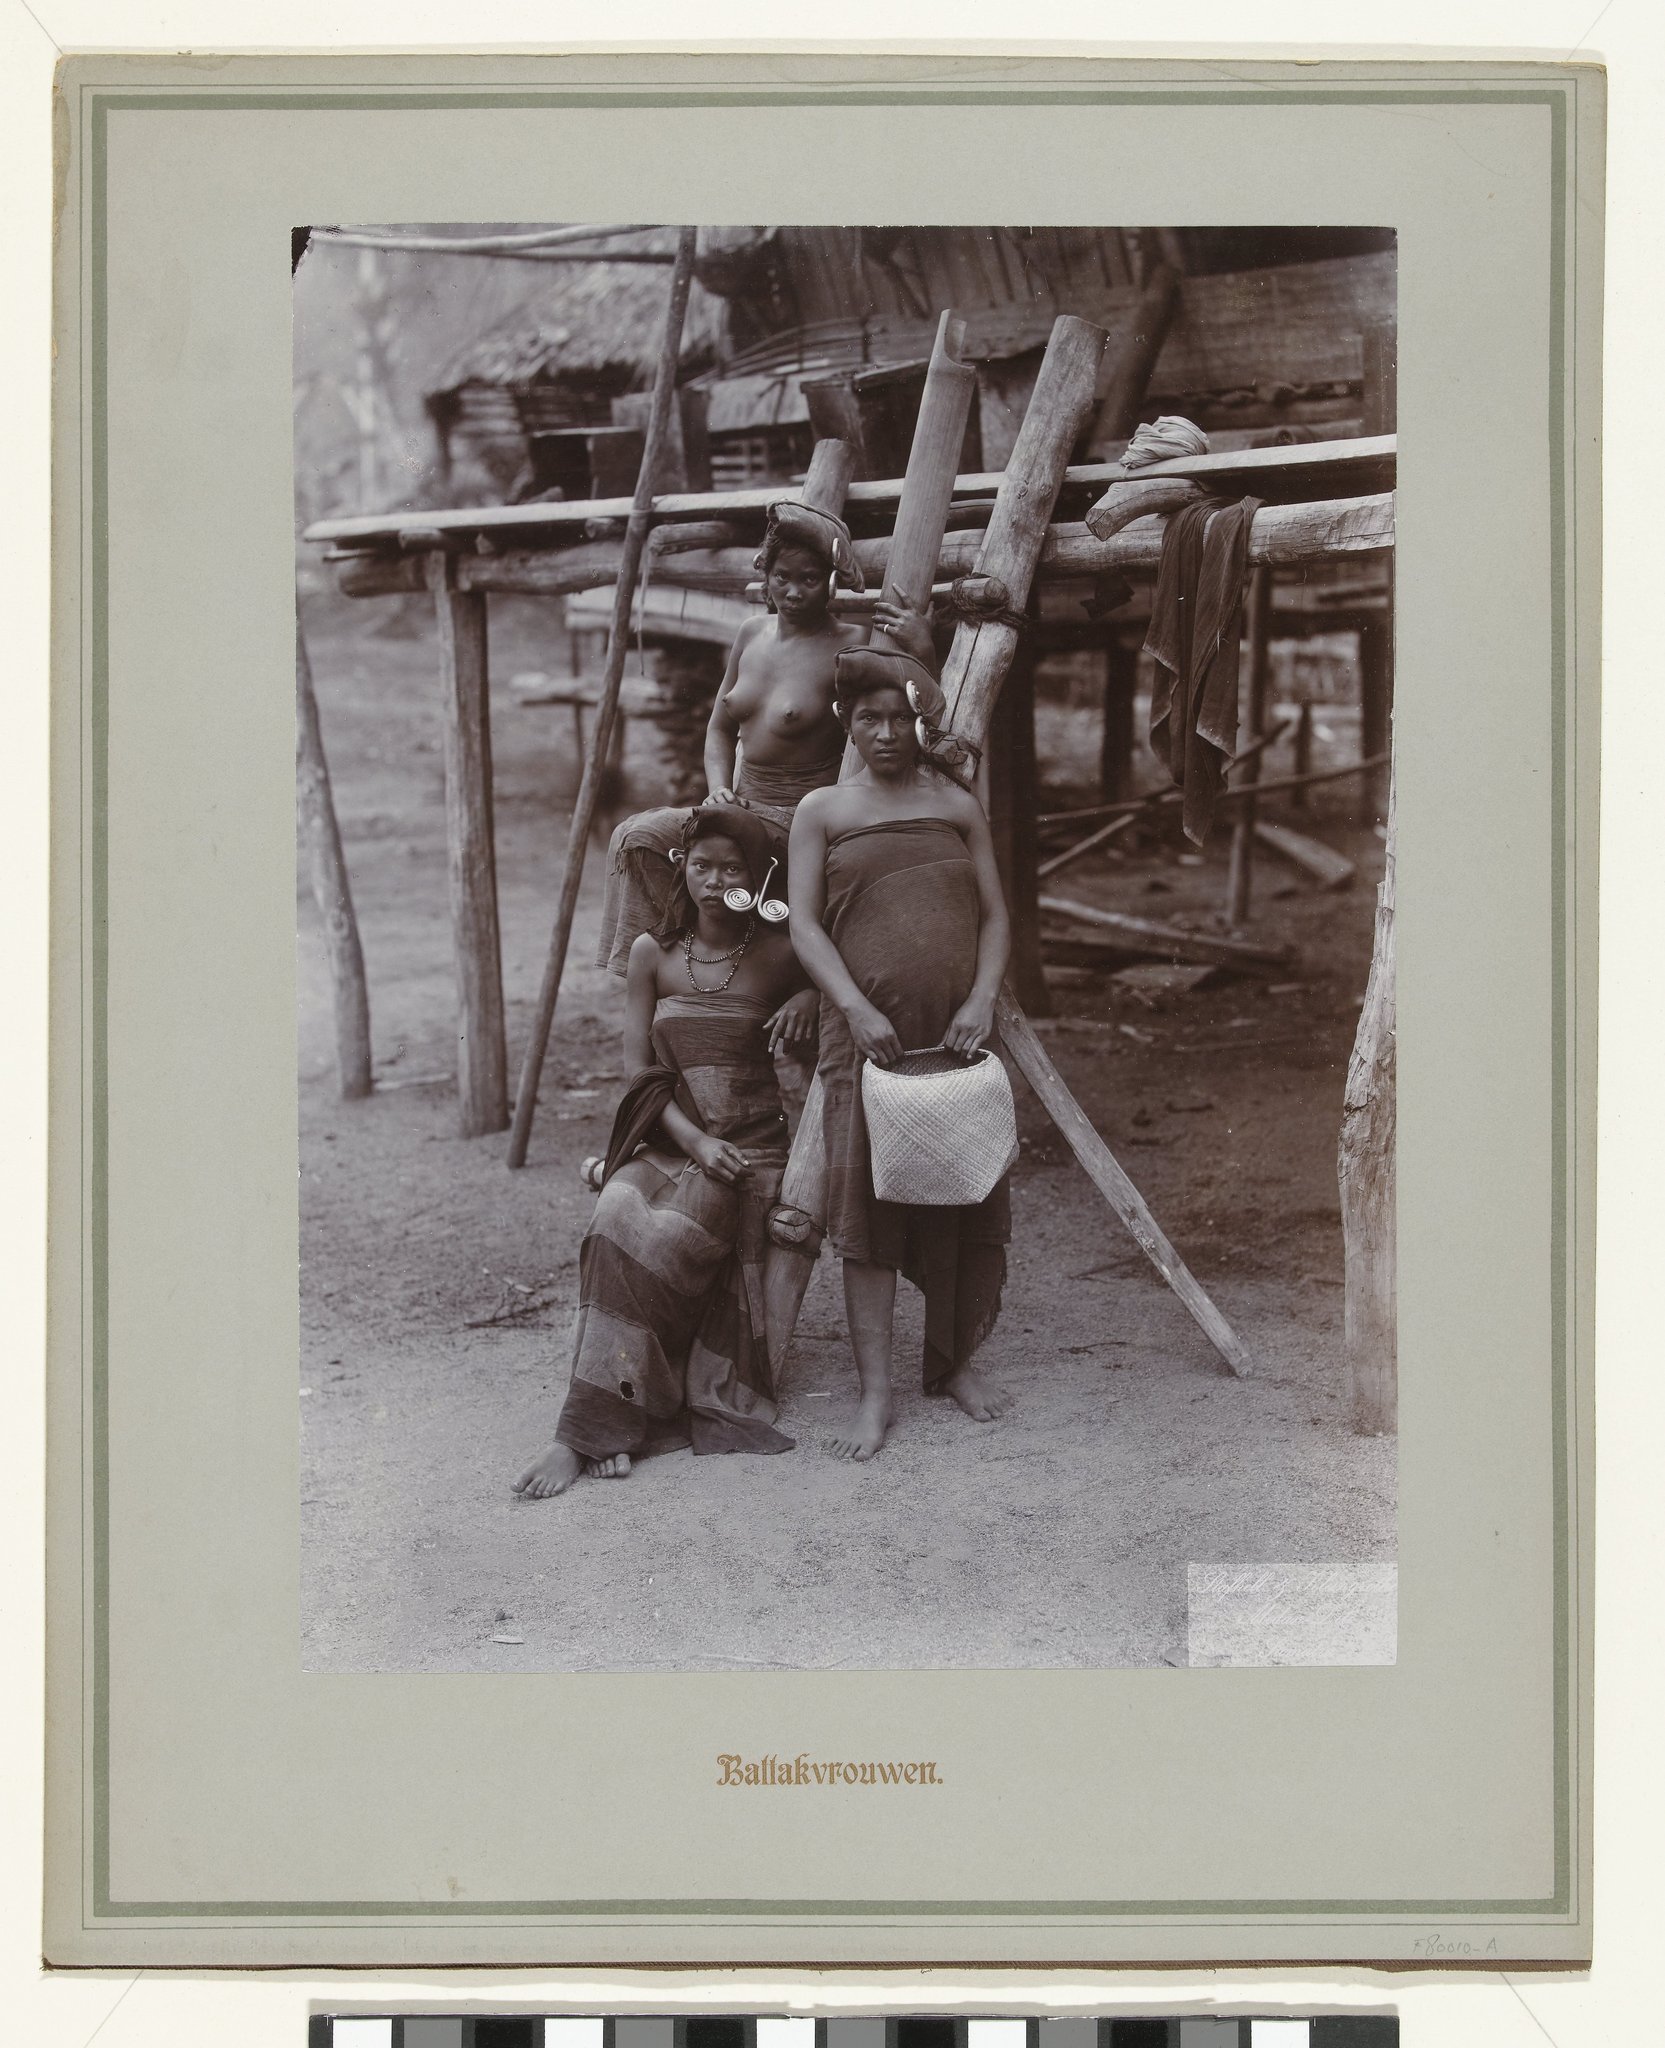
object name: photograph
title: Battakvrouwen op Sumatra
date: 1890-1900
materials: cardboard, paper, photographic support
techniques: collodion silver print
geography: medan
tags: asiatic races and peoples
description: Battakvrouwen op Sumatra. Foto geplakt op losgesneden blad uit album, op verso bevindt zich nog een foto uit dezelfde serie.